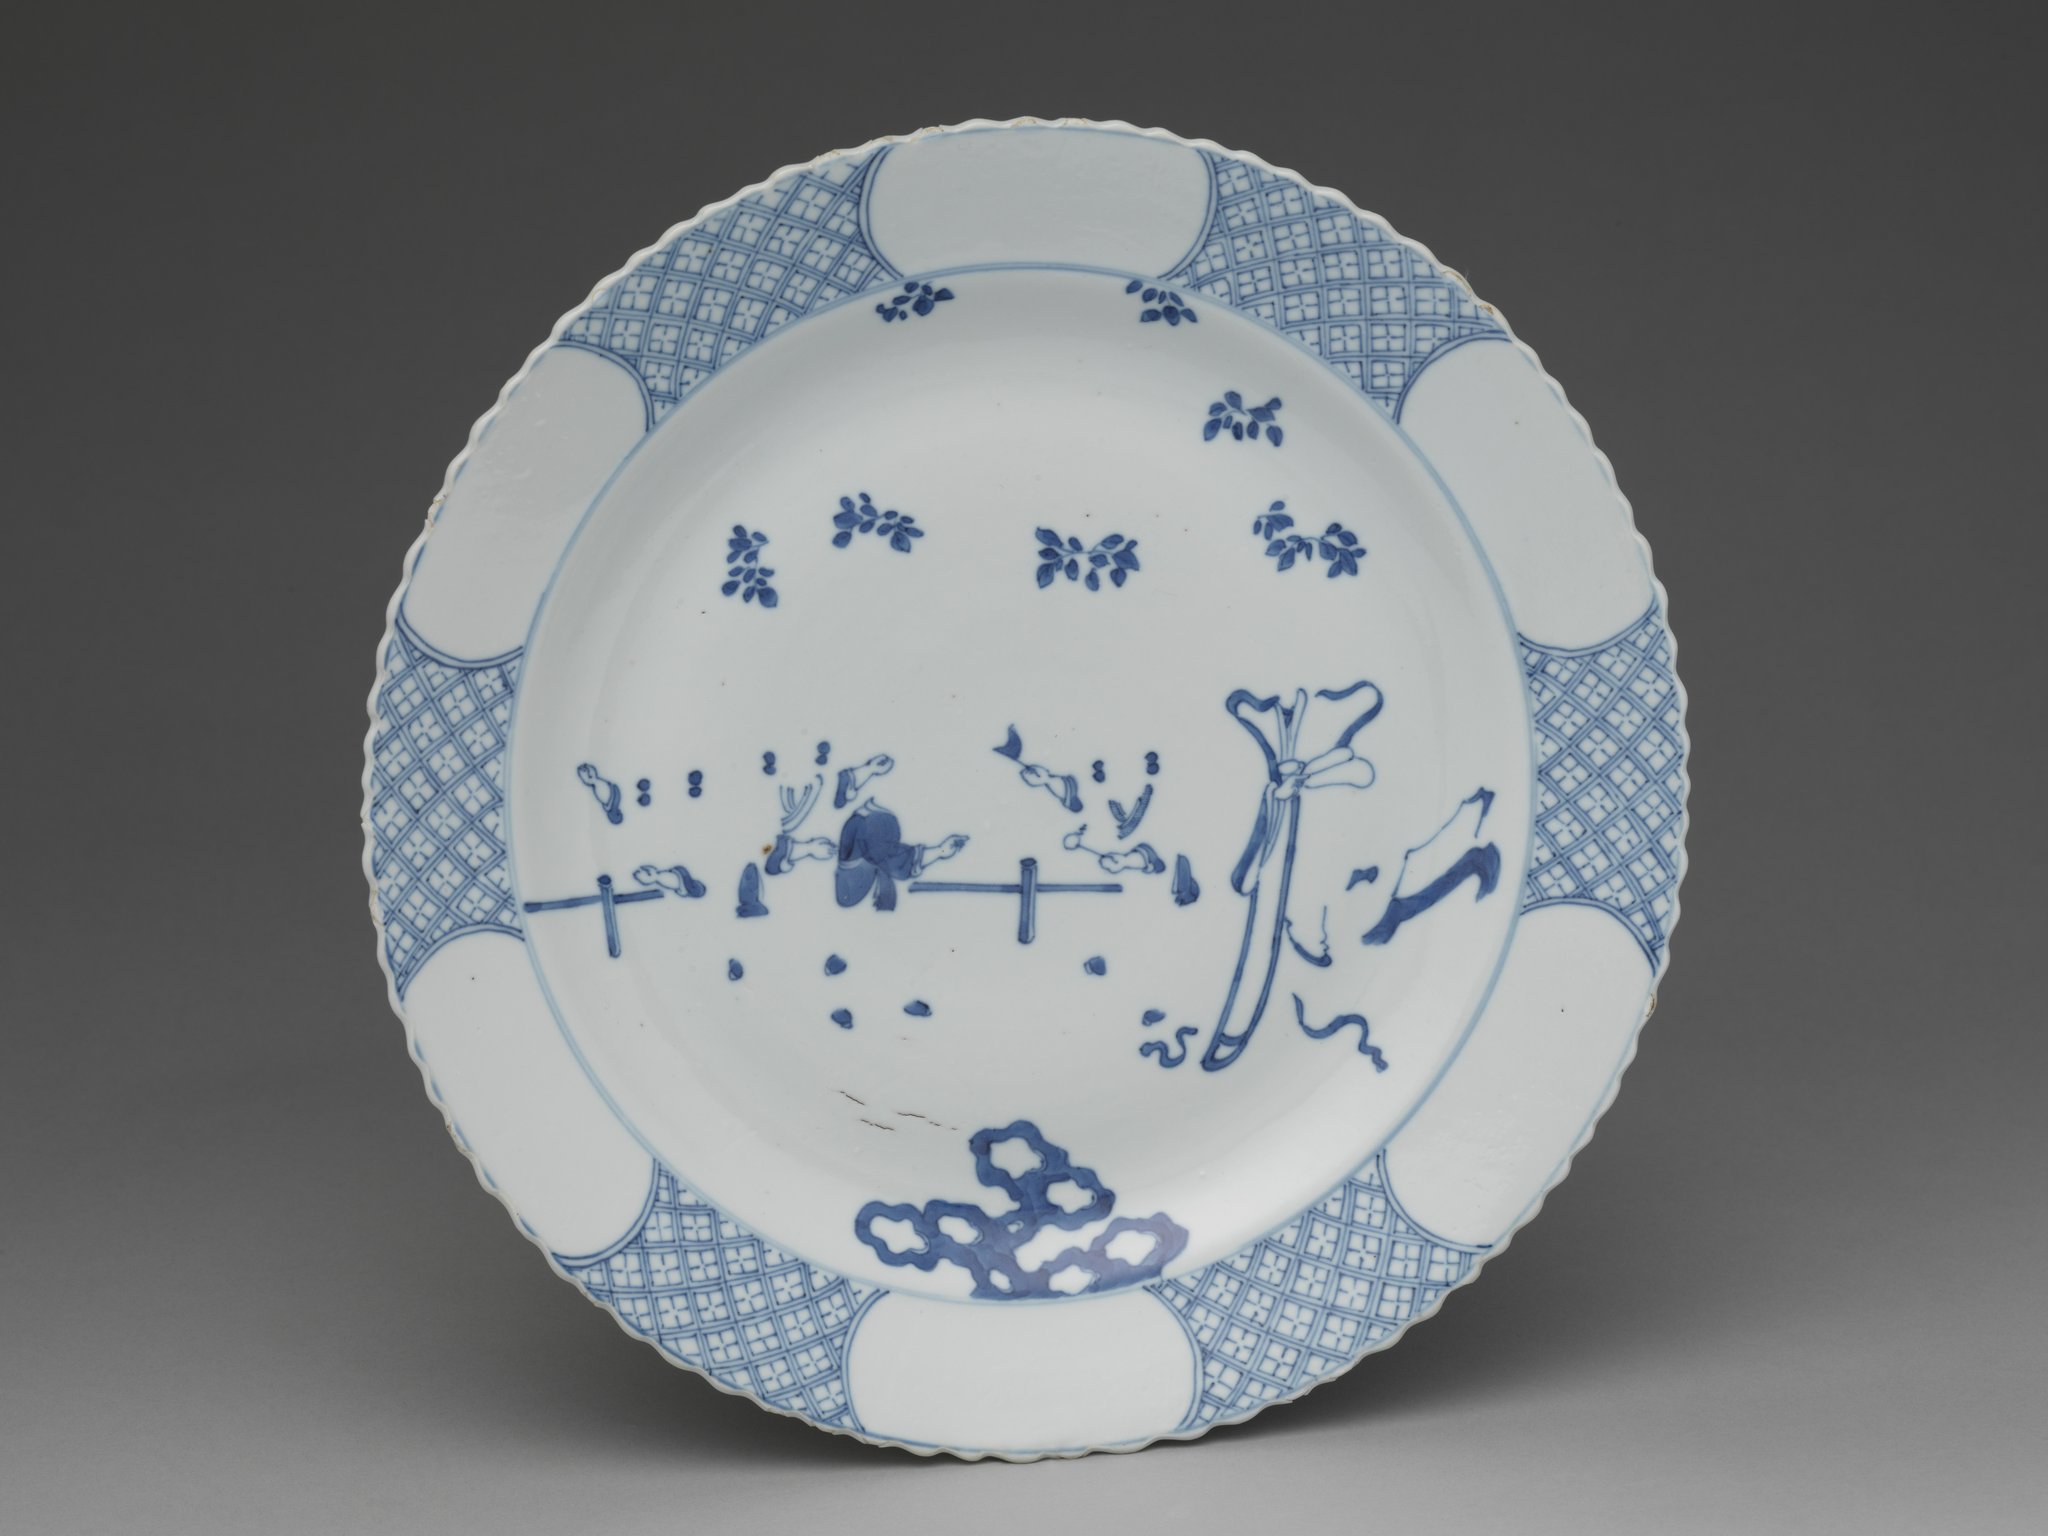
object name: dish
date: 1725-1740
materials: hard paste porcelain